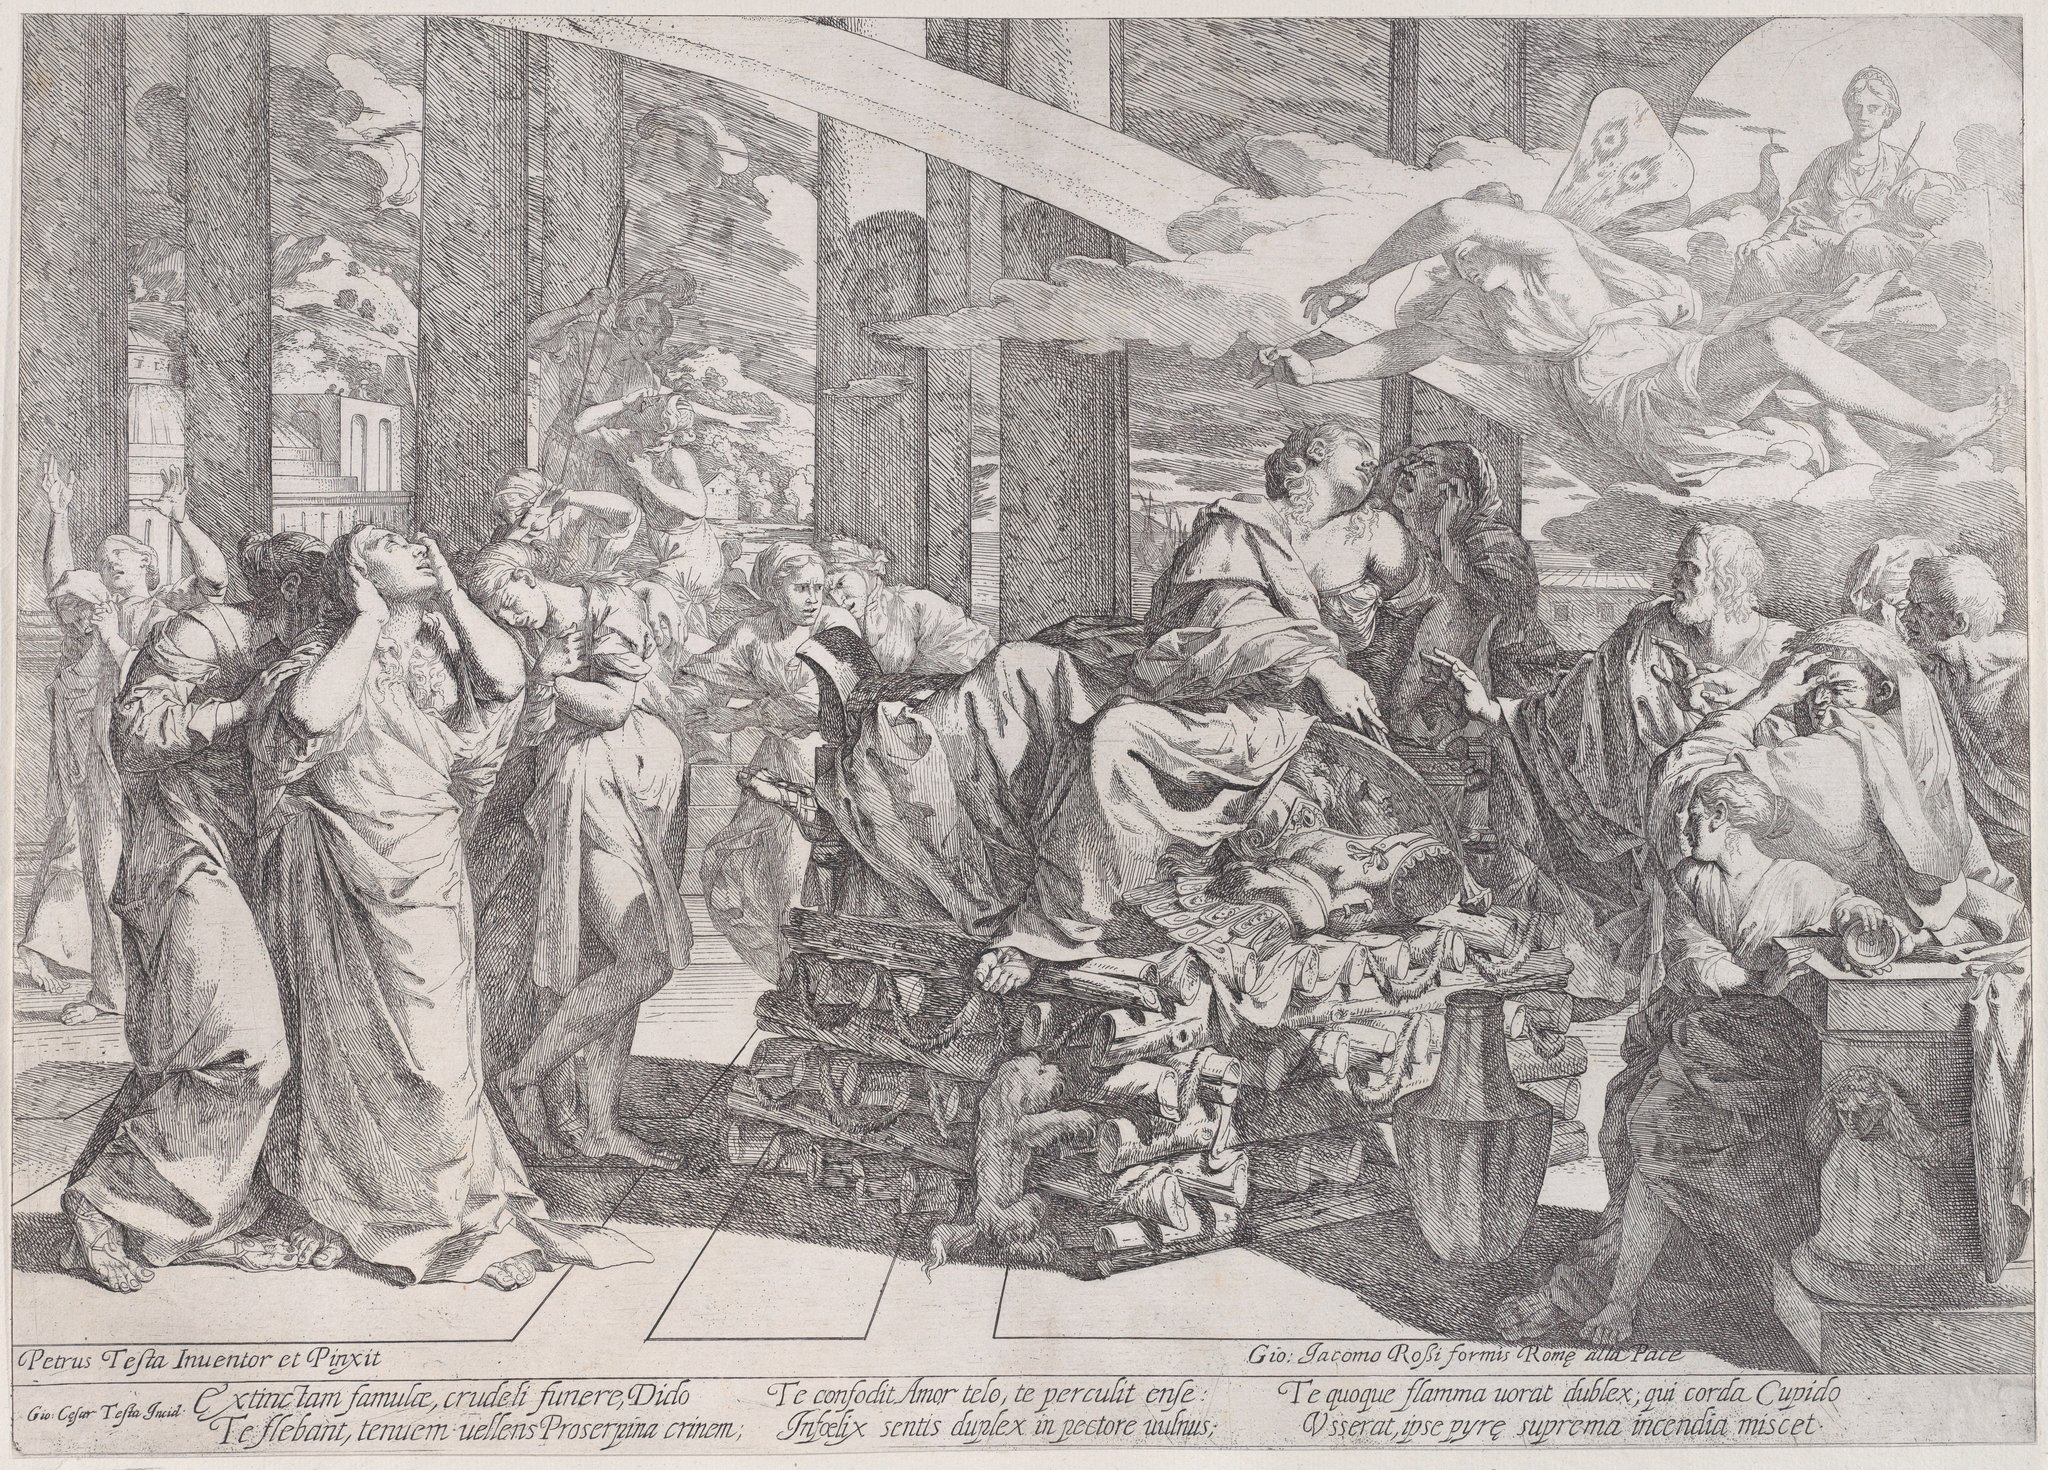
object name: print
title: The suicide of Dido who reclines on a pyre in centre, surrounded by many figures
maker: giovanni cesare testa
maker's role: artist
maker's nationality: italian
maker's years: 1630-1655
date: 1650-1655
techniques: etching